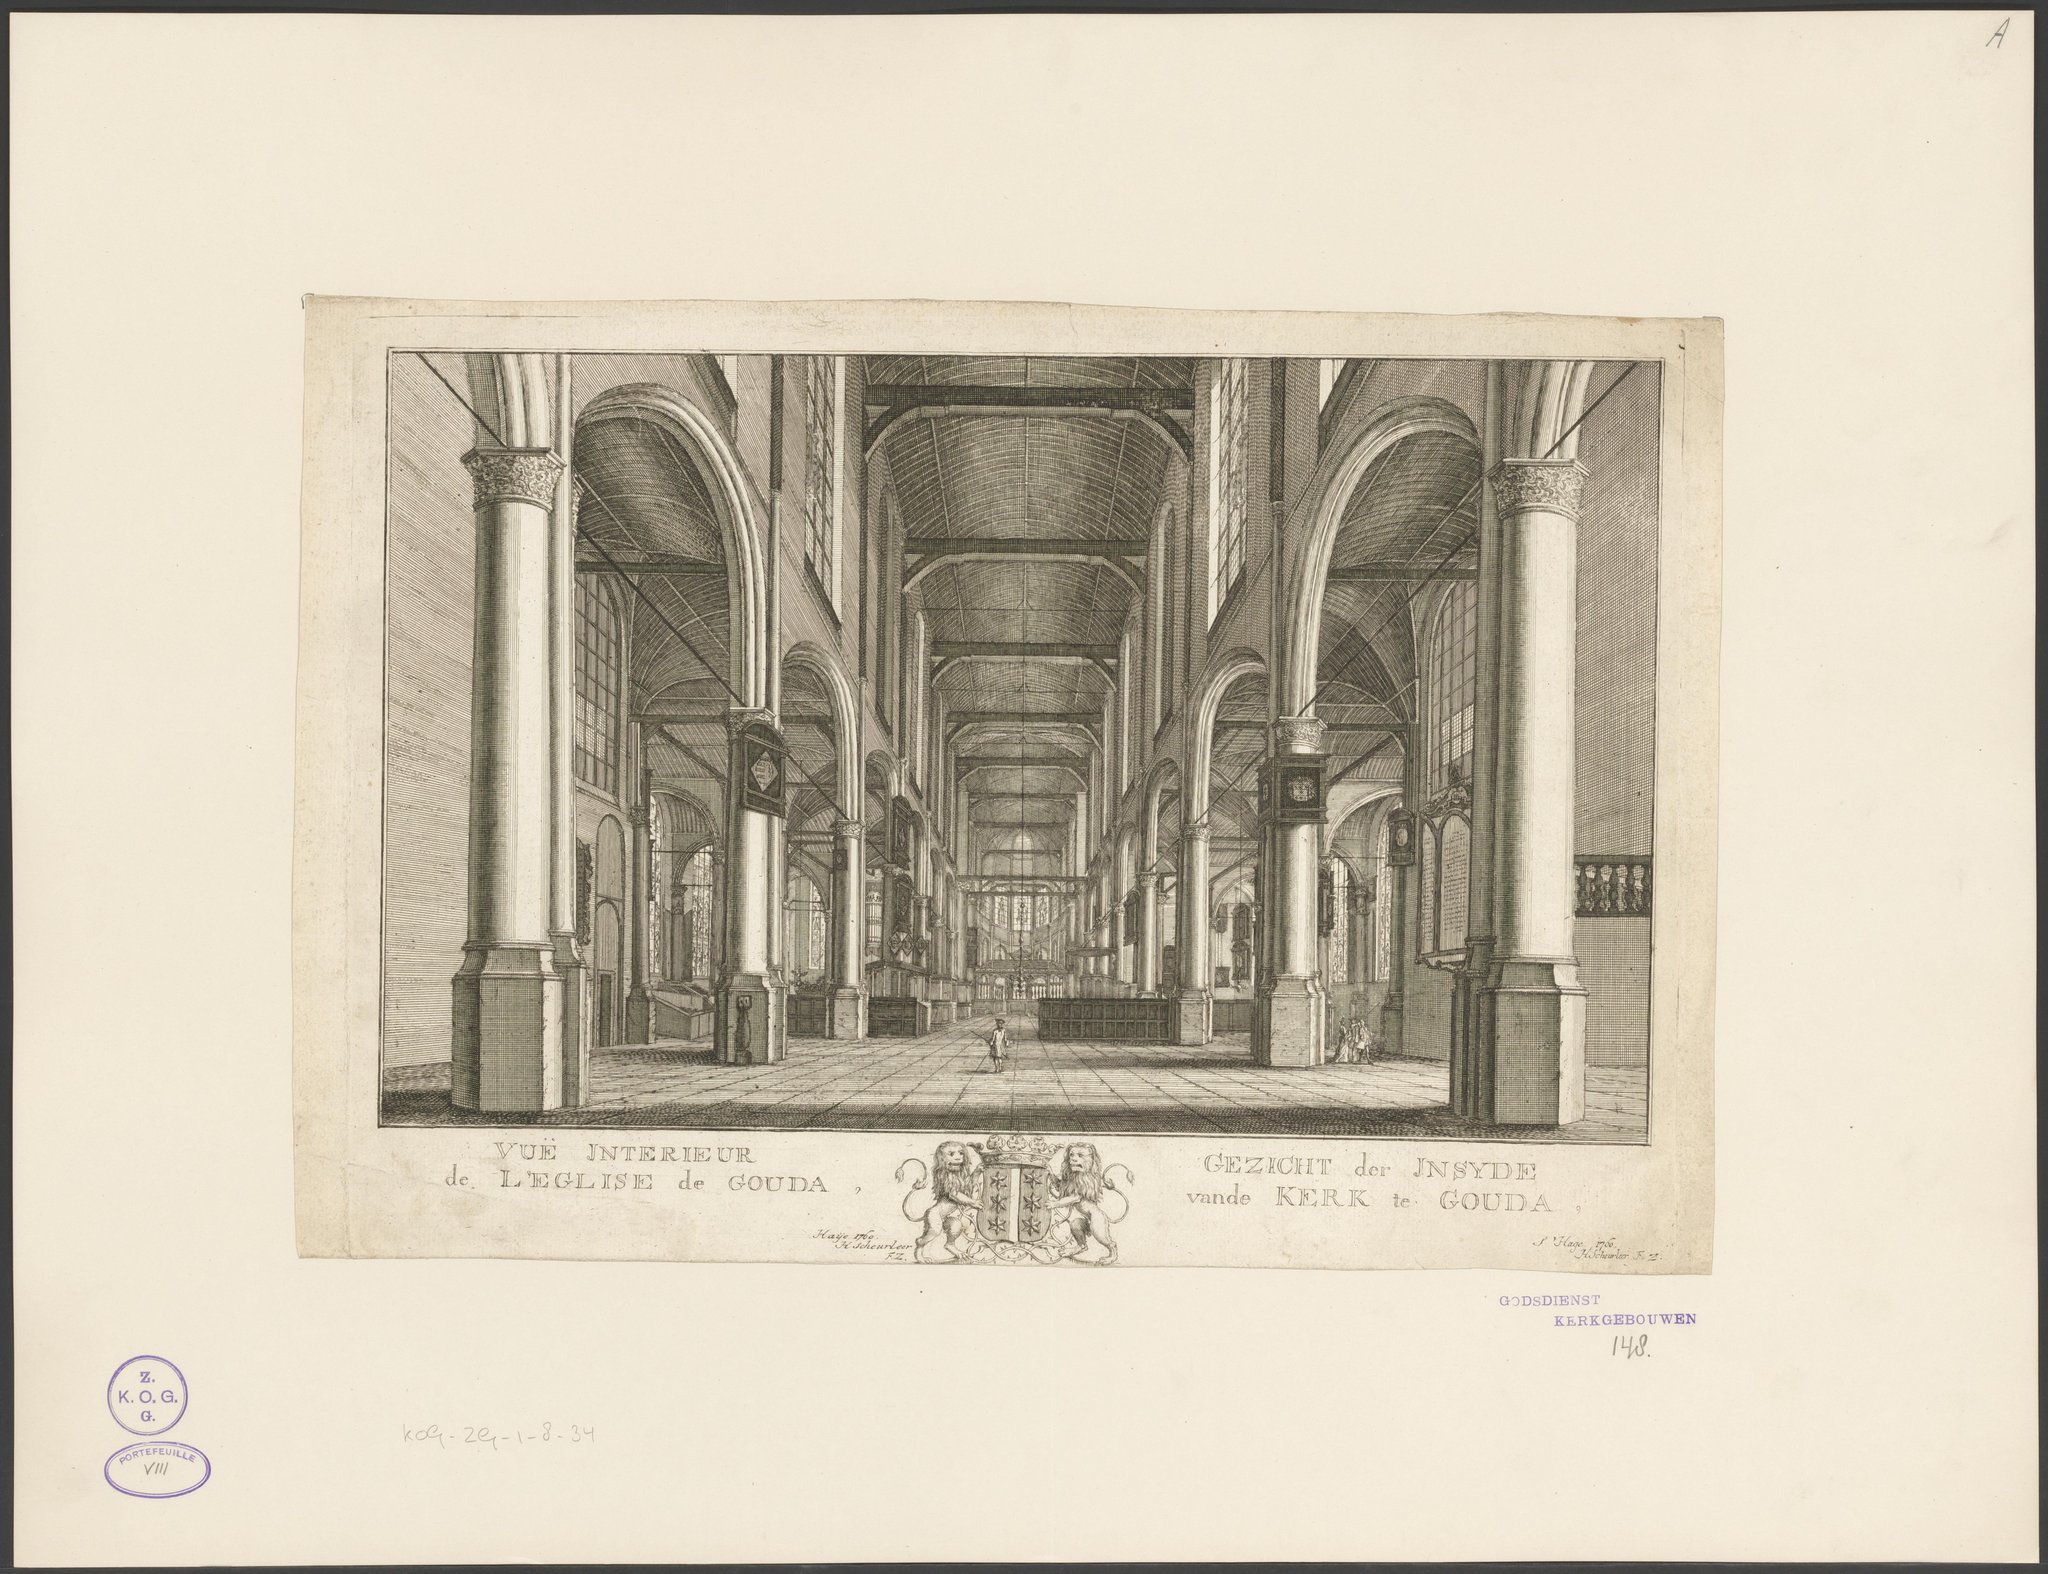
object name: print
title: Interieur van de Sint-Janskerk te Gouda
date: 1760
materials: paper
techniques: engraving, etching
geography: the hague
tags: device (as symbol of the state, etc.) (+ city; municipal), interior of church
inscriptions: collector's mark, collector's mark: Lugt 1641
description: Het interieur van de Sint-Janskerk te Gouda. In de kerk staan enkele figuren. In de marge het stadswapen van Gouda. Onderwerpsrubrieken binnen de Atlas Zeden en Gewoonten: Kerk en kerkwezen & Armwezen en liefdadige instellingen; Kerkgebouwen elders. F-L.